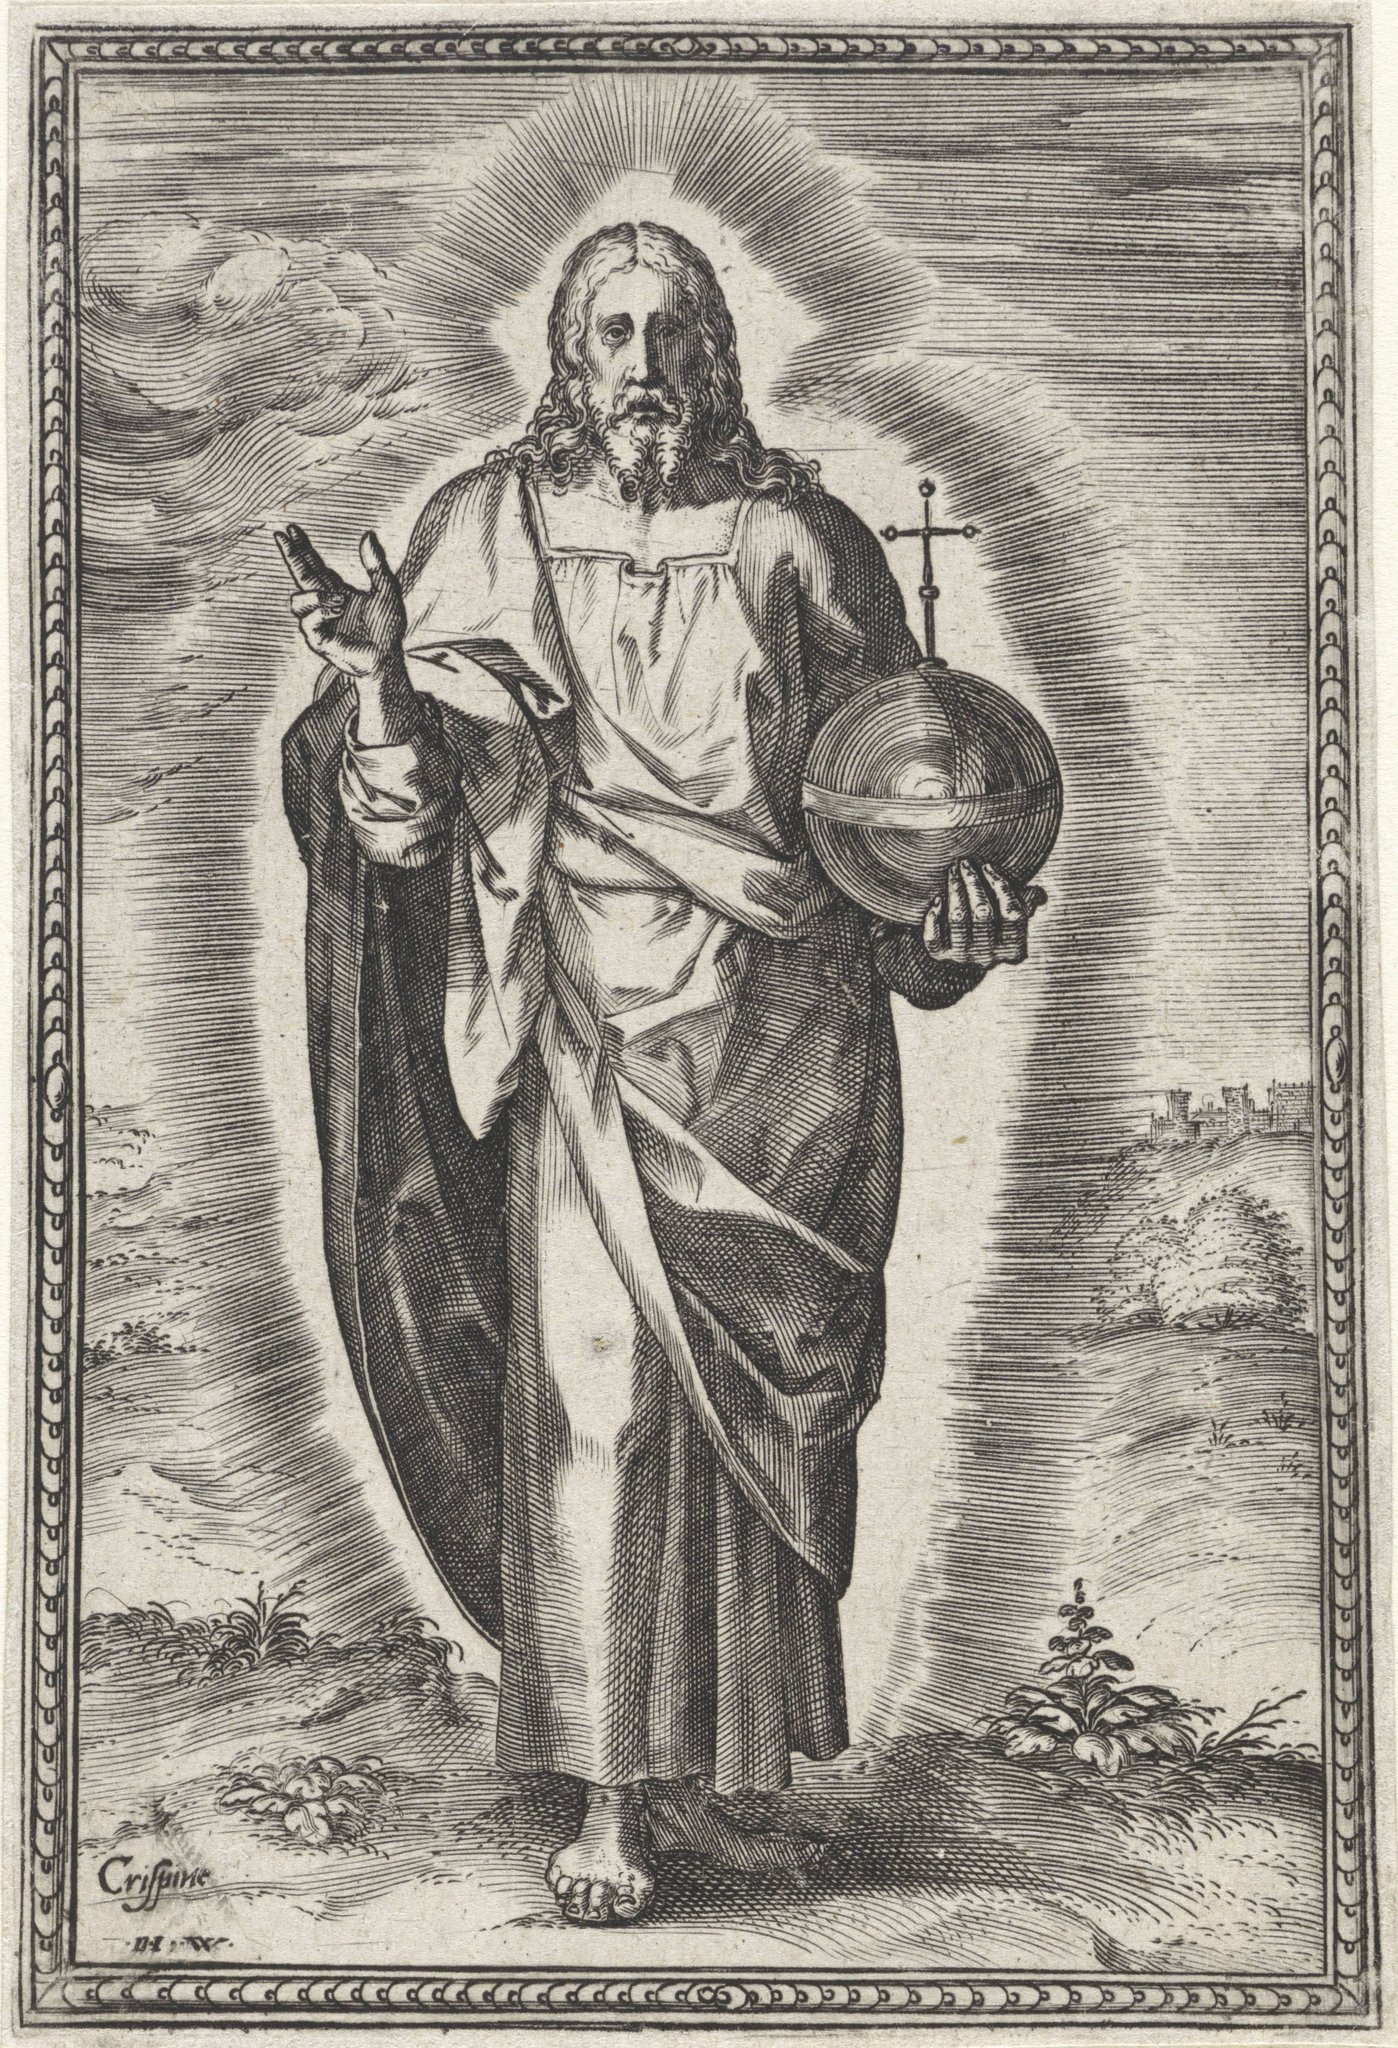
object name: print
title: Christus en de twaalf apostelen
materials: paper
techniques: engraving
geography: antwerp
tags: adult christ together with apostles, evangelists, saints, etc.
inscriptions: collector's mark: Lugt 2228, number: ‘38. - 84.’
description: Christus maakt een zegenend gebaar met zijn ene hand, in de andere hand houdt hij een rijksappel. Rond hem een aureool.